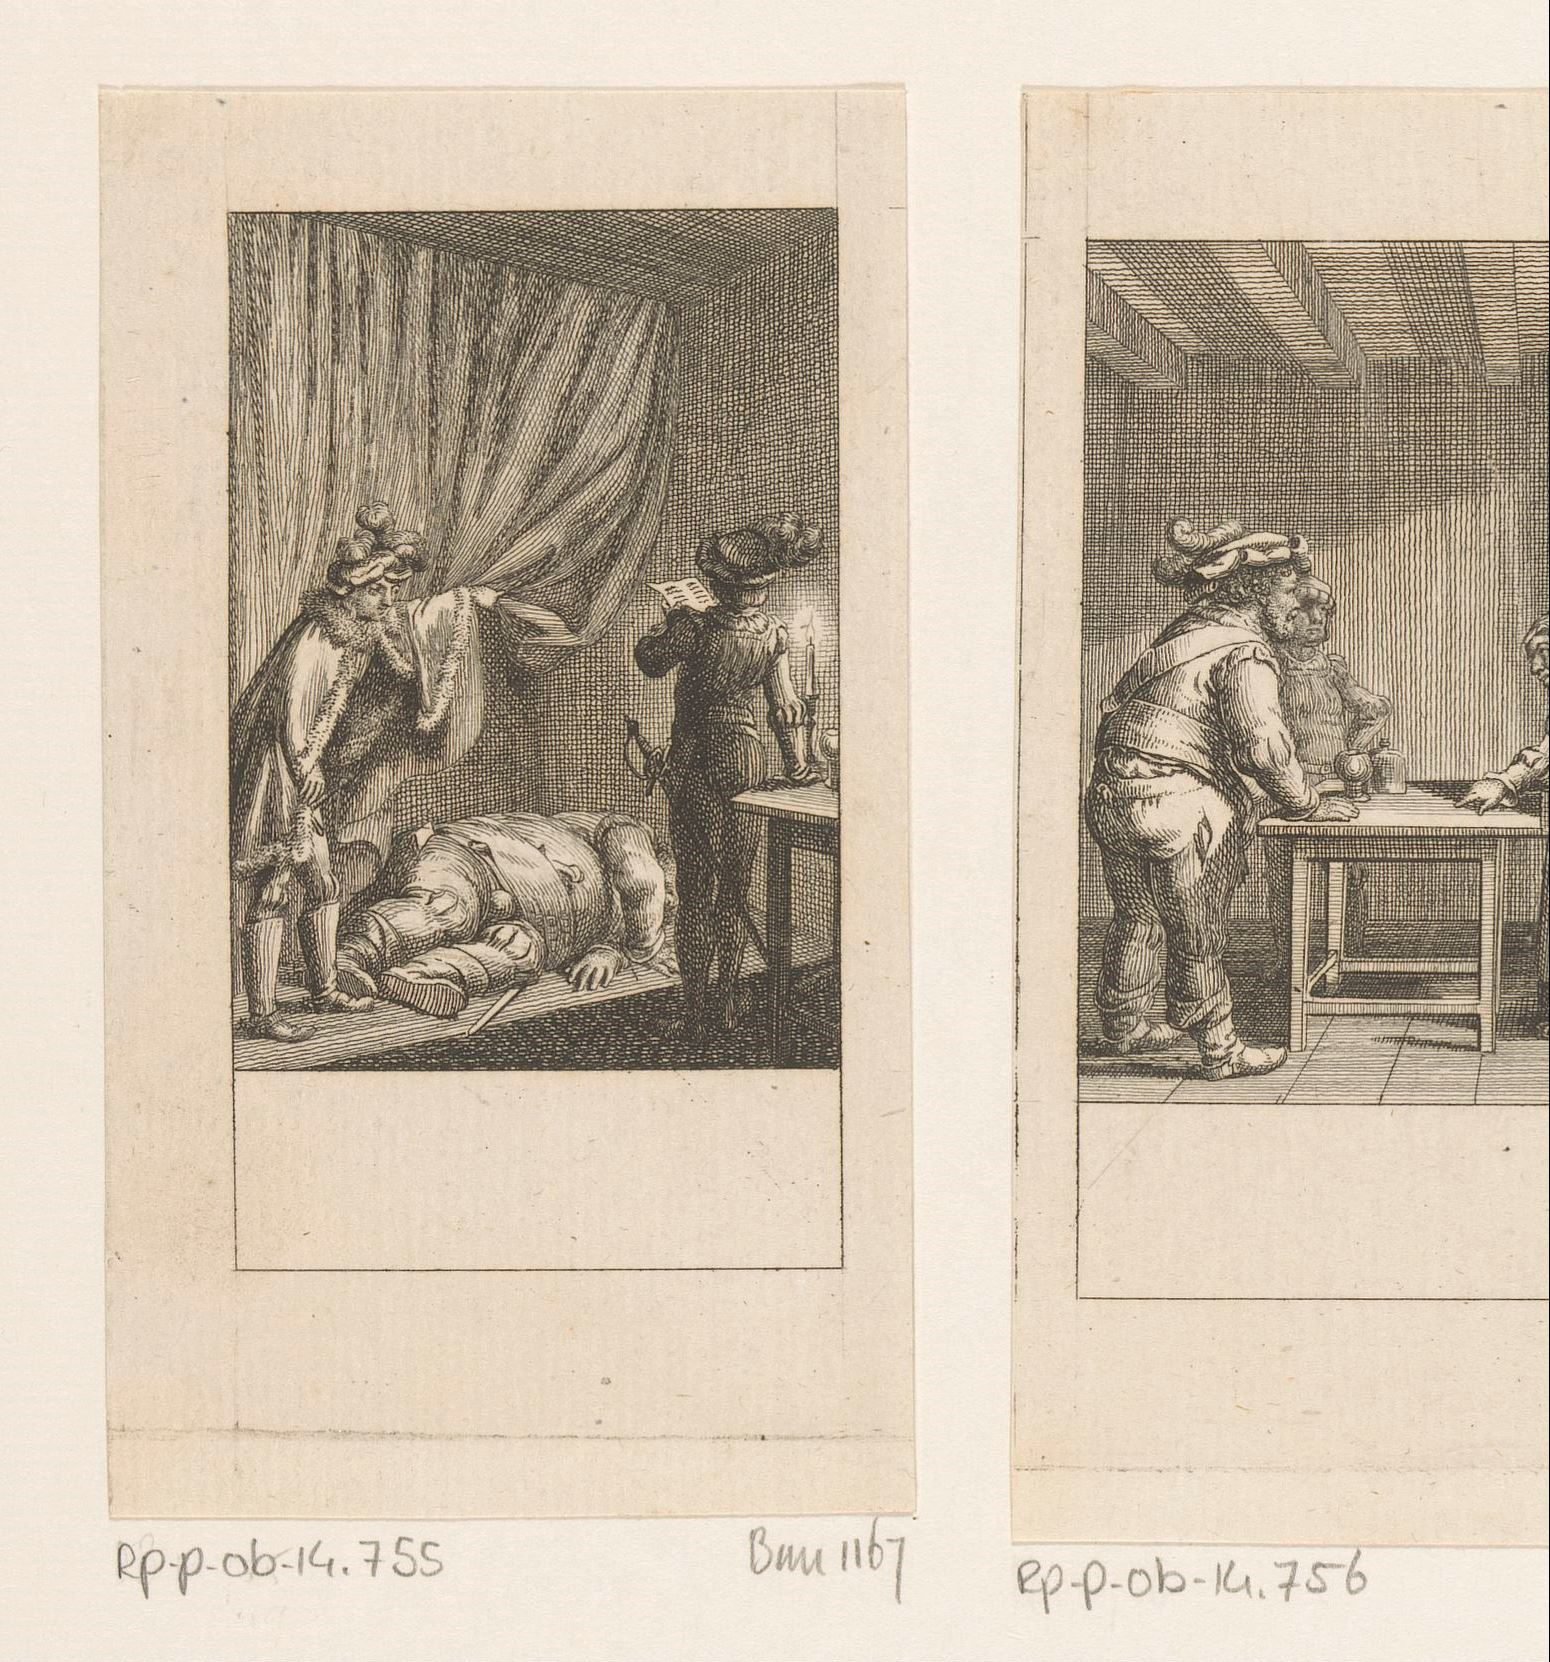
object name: print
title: Henry en Poins doorzoeken de spullen van Falstaff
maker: daniel nikolaus chodowiecki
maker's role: draughtsman, print maker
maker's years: 1726-1801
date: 1785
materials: paper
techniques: etching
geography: berlin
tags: william shakespeare, curtains, literature, sleeping; unconsciousness, falstaff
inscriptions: collector's mark: Lugt 2228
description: Vervaardigd voor William Shakespeares 'Henry IV'. Latere staat gebruikt voor: Goettinger Taschen Calender vom Jahr 1786. Göttingen: Johann Christoph Dietrich, 1785.